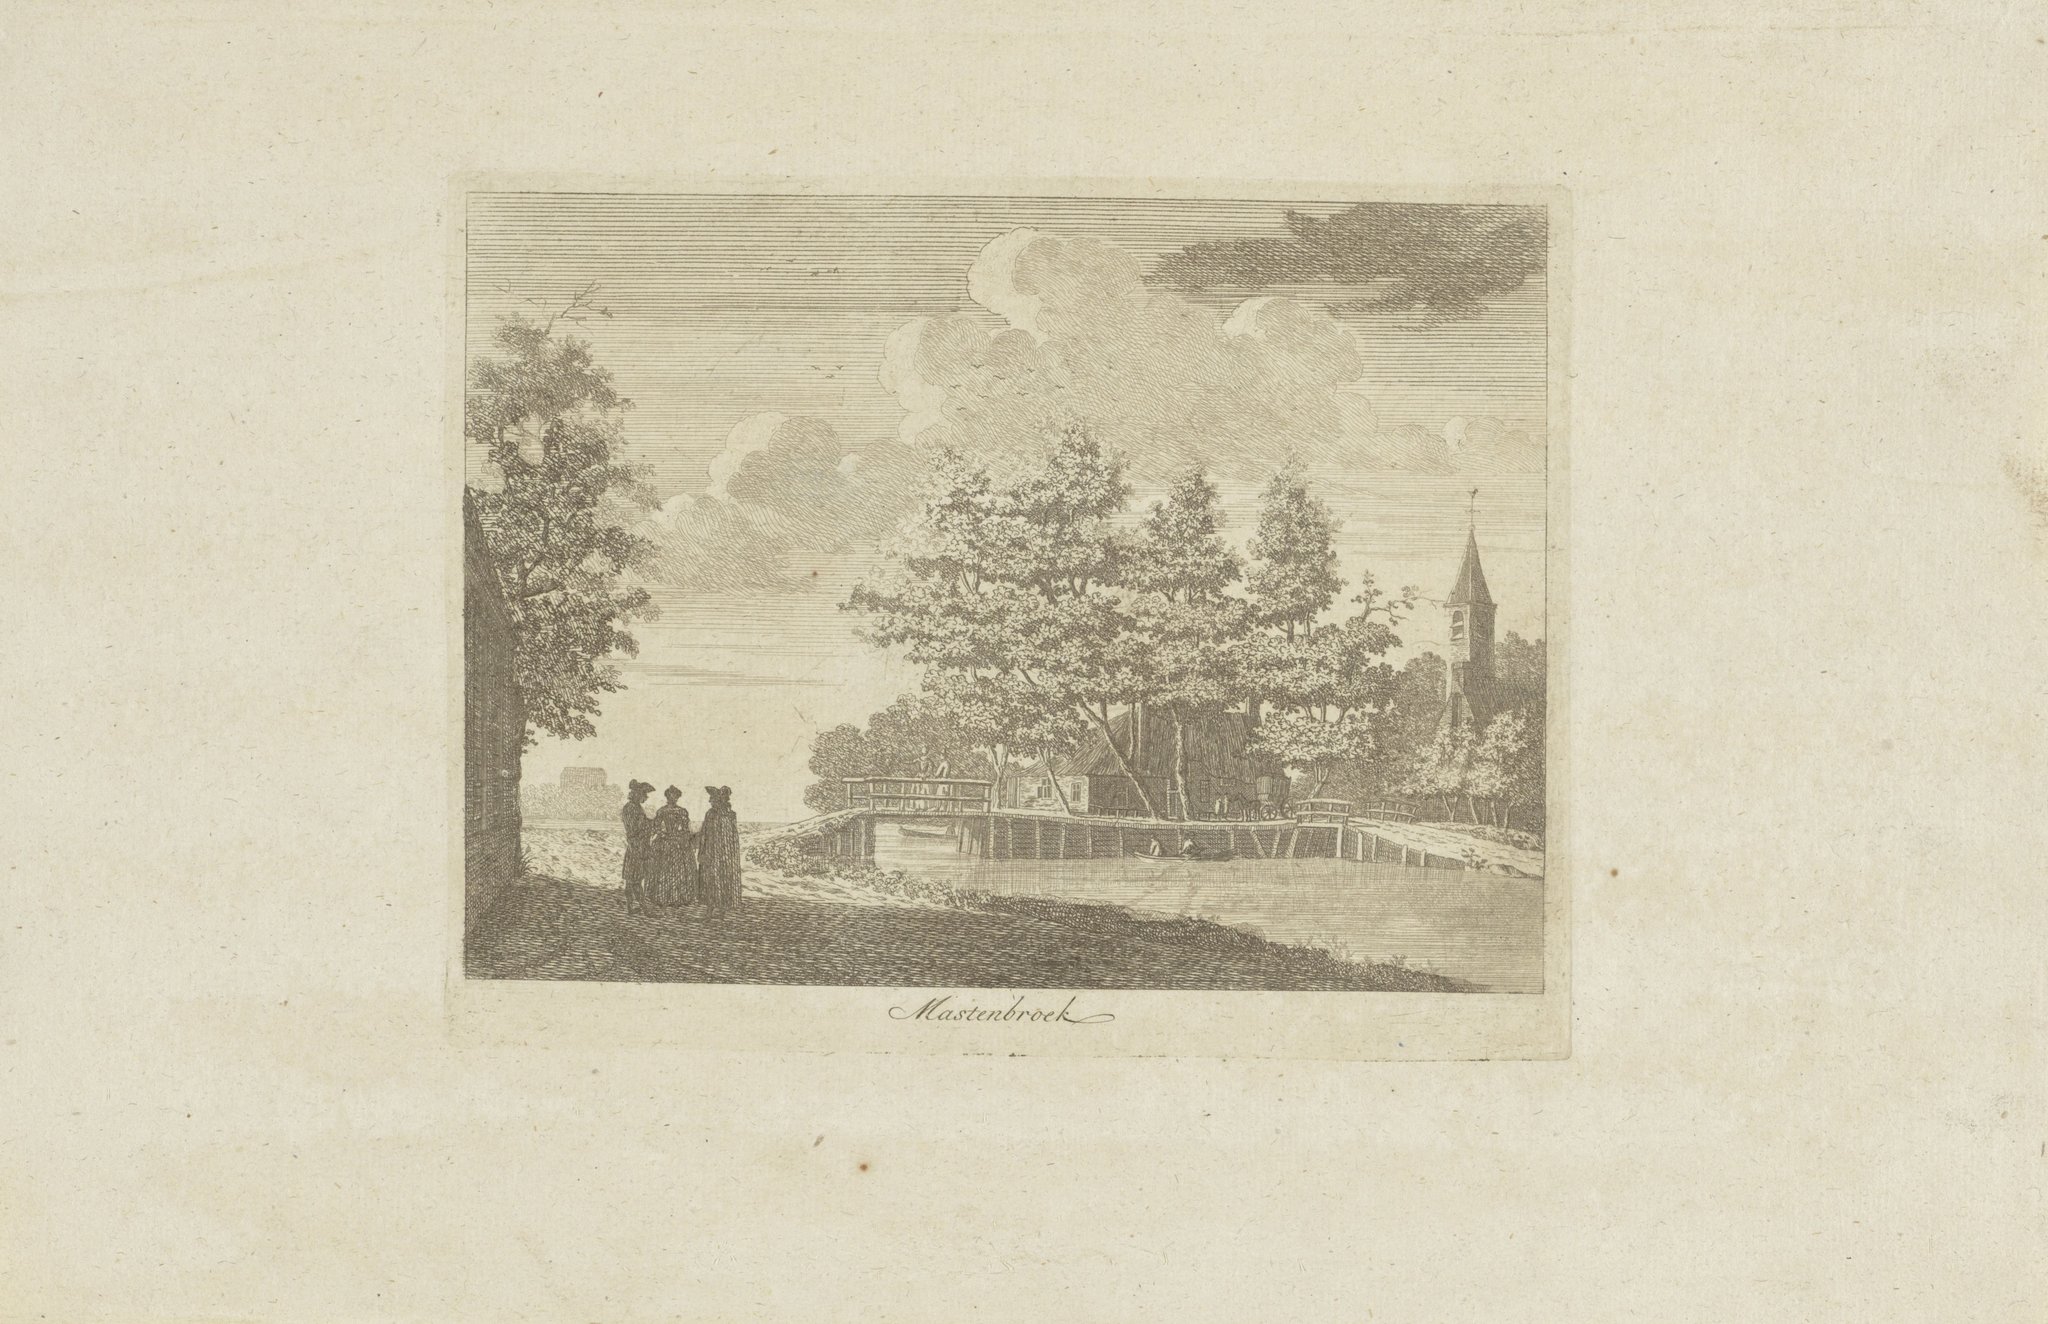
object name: print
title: Mastenbroek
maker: hendrik spilman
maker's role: draughtsman, painter, print maker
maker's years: 1721-1784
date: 1742-1784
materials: paper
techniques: etching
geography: haarlem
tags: church (exterior), polder, reclaimed land, bridge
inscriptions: collector's mark: Lugt 2228